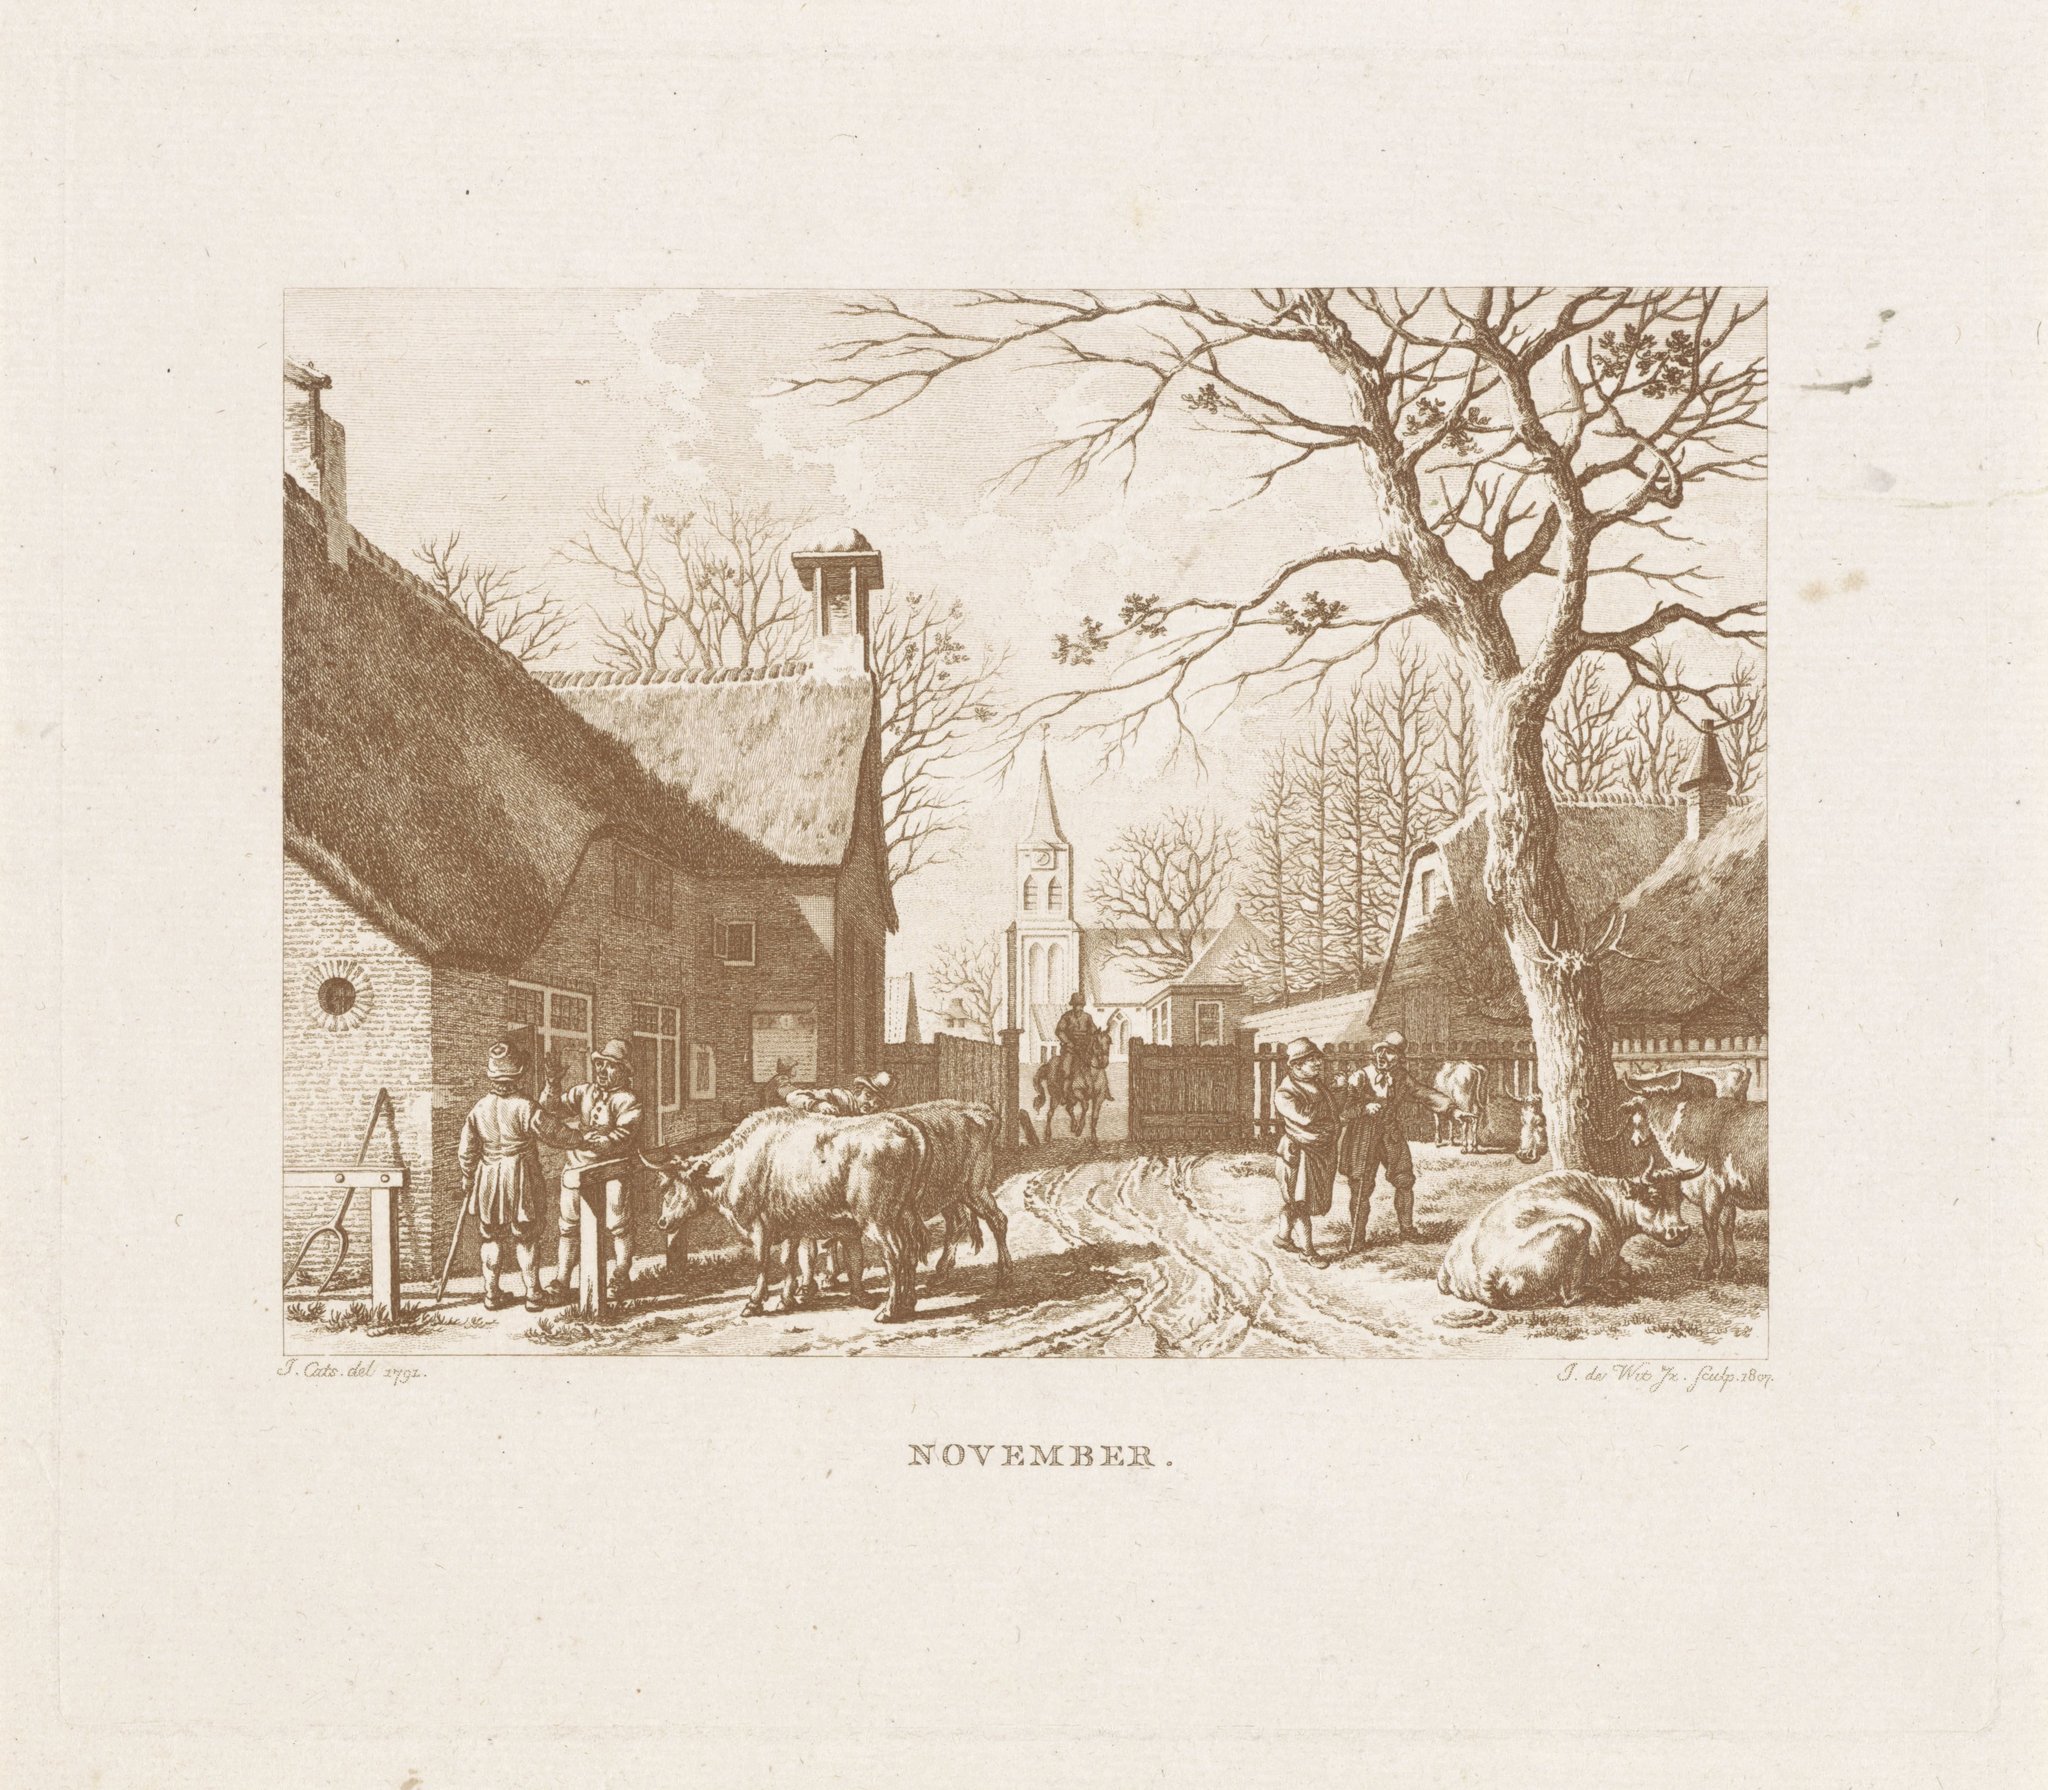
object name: print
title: Boeren onderhandelen bij ossen in een dorp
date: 1807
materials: paper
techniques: etching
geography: haarlem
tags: november and its 'labours' (+ with scenes showing human occupations ~ seasons and months), public road in village, market, bovine cattle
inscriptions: collector's mark: Lugt 2228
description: Gezicht in een dorp met op de voorgrond onderhandelende boeren bij ossen. Een kerk op de achtergrond.